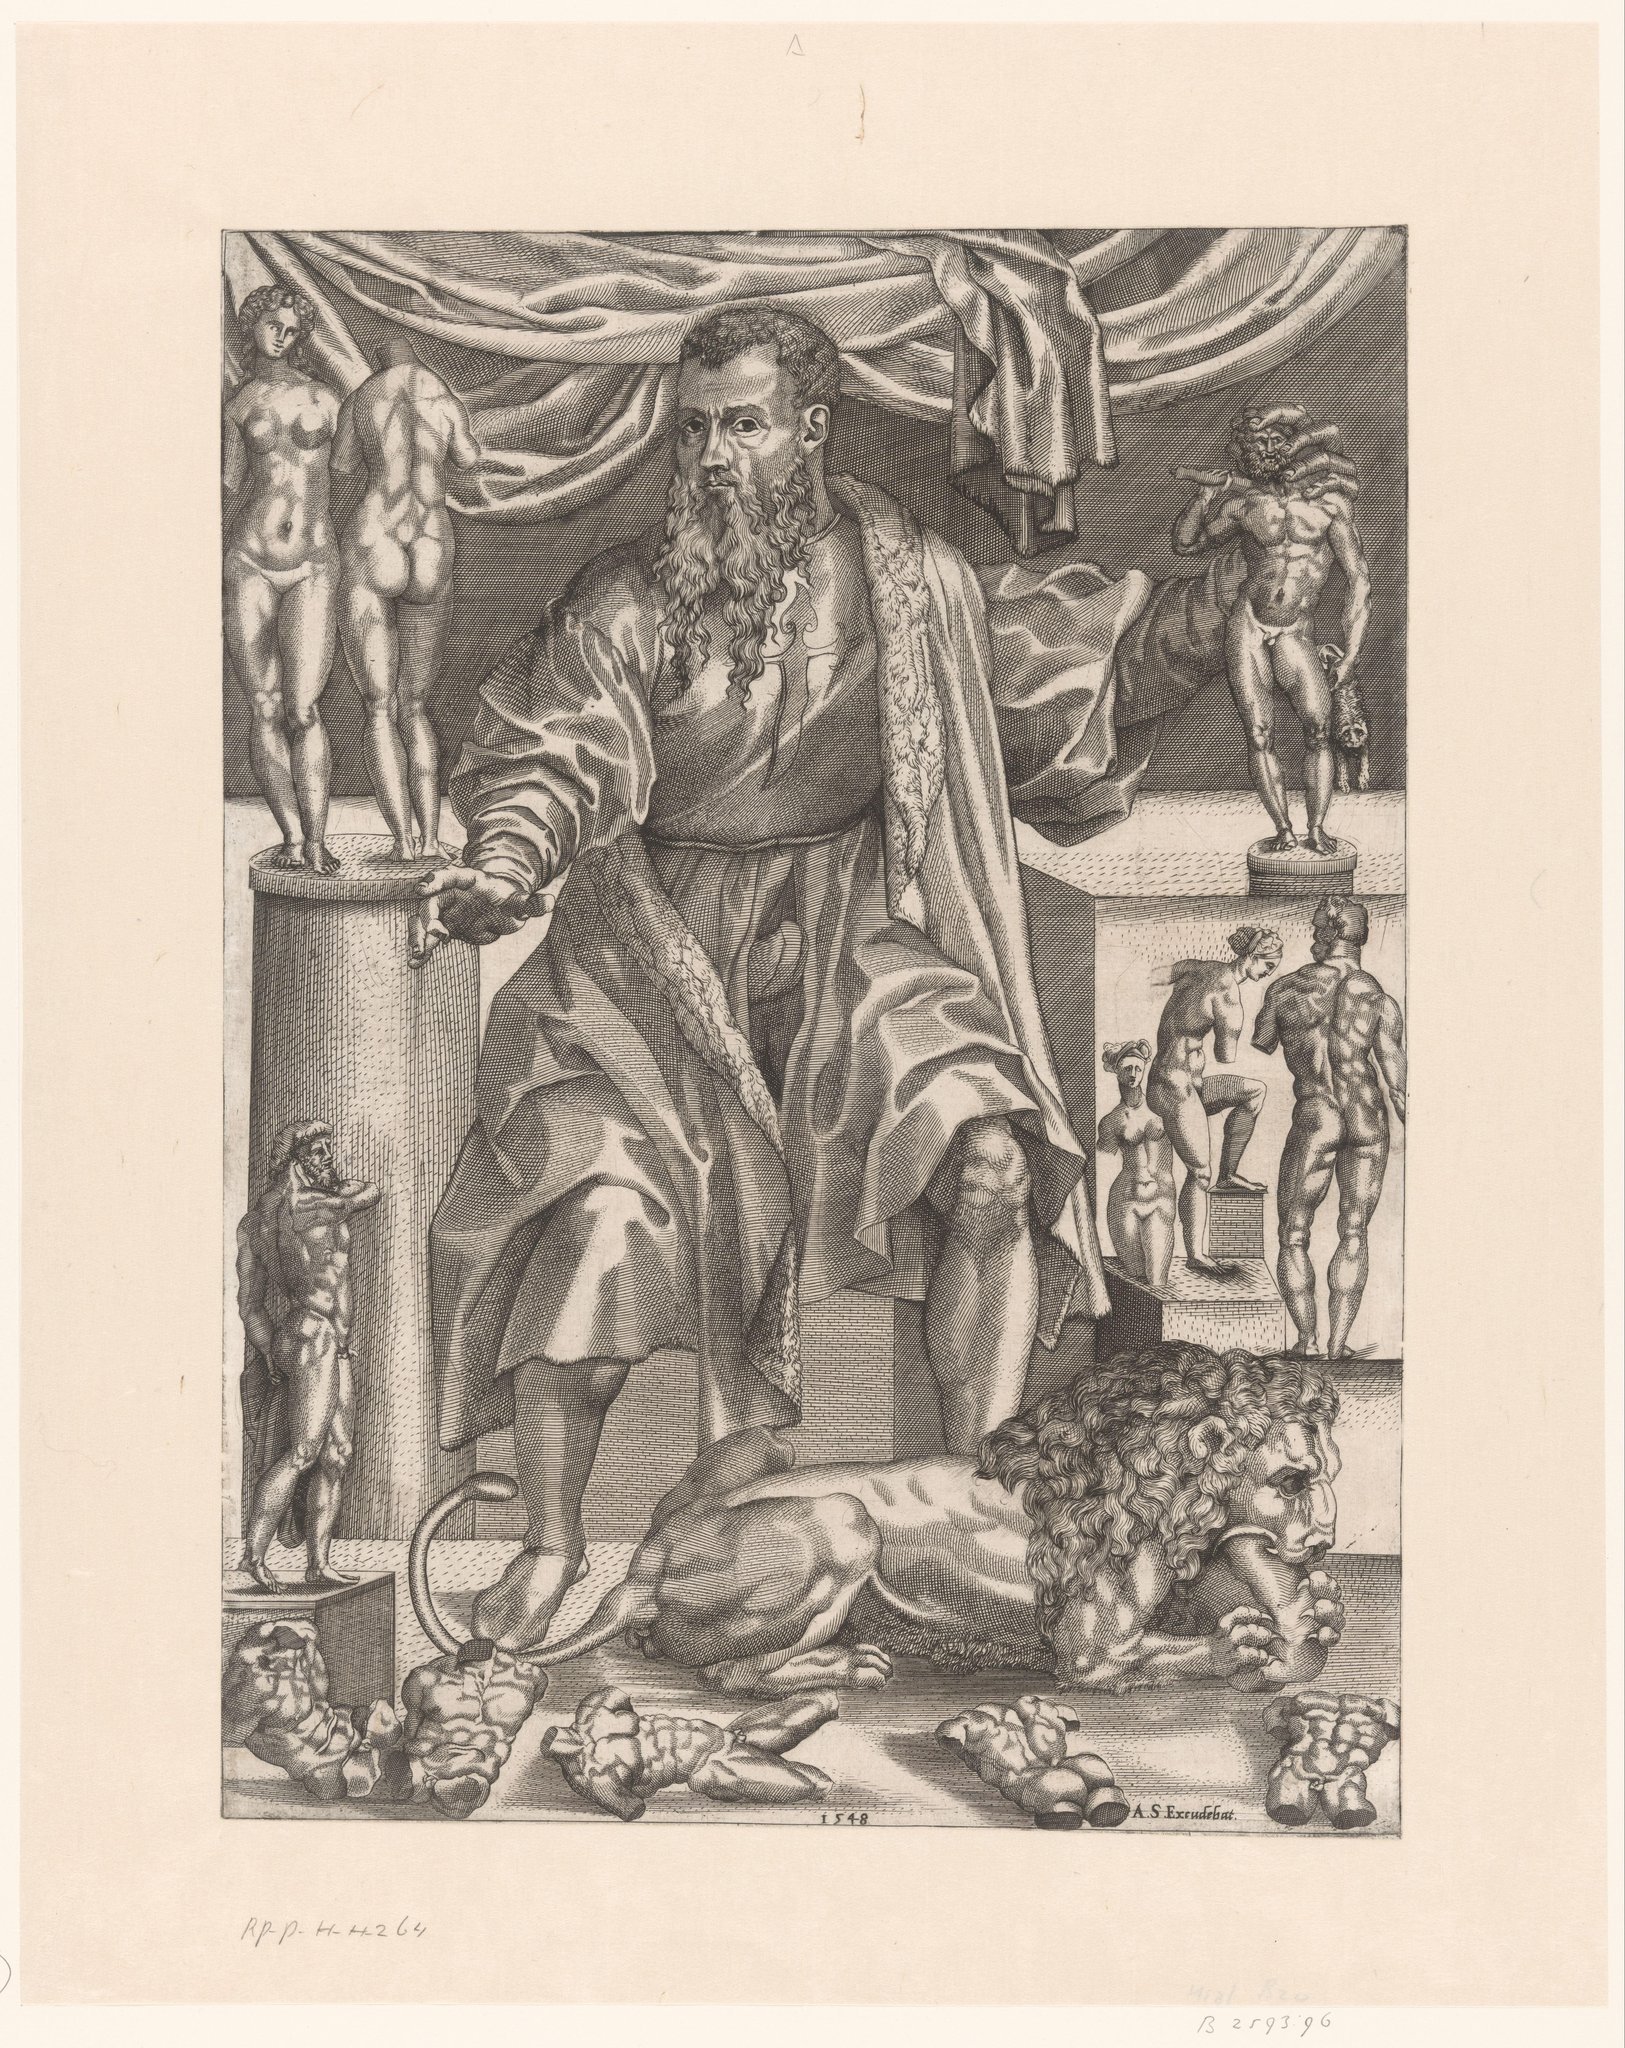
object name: print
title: The sculptor Baccio Bandinelli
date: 1548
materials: paper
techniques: engraving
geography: italy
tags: draughtsman, baccio bandinelli, portrait, self-portrait of sculptor, historical persons, piece of sculpture, reproduction of a piece of sculpture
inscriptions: date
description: In this portrait the Florentine sculptor Bandinelli is surrounded by several of his models. In his left hand he holds a statuette of Hercules, whose pose is virtually the same (but in reverse) as the torso by Van der Schardt on view here. It demonstrates how identical models were used as study material by different artists.